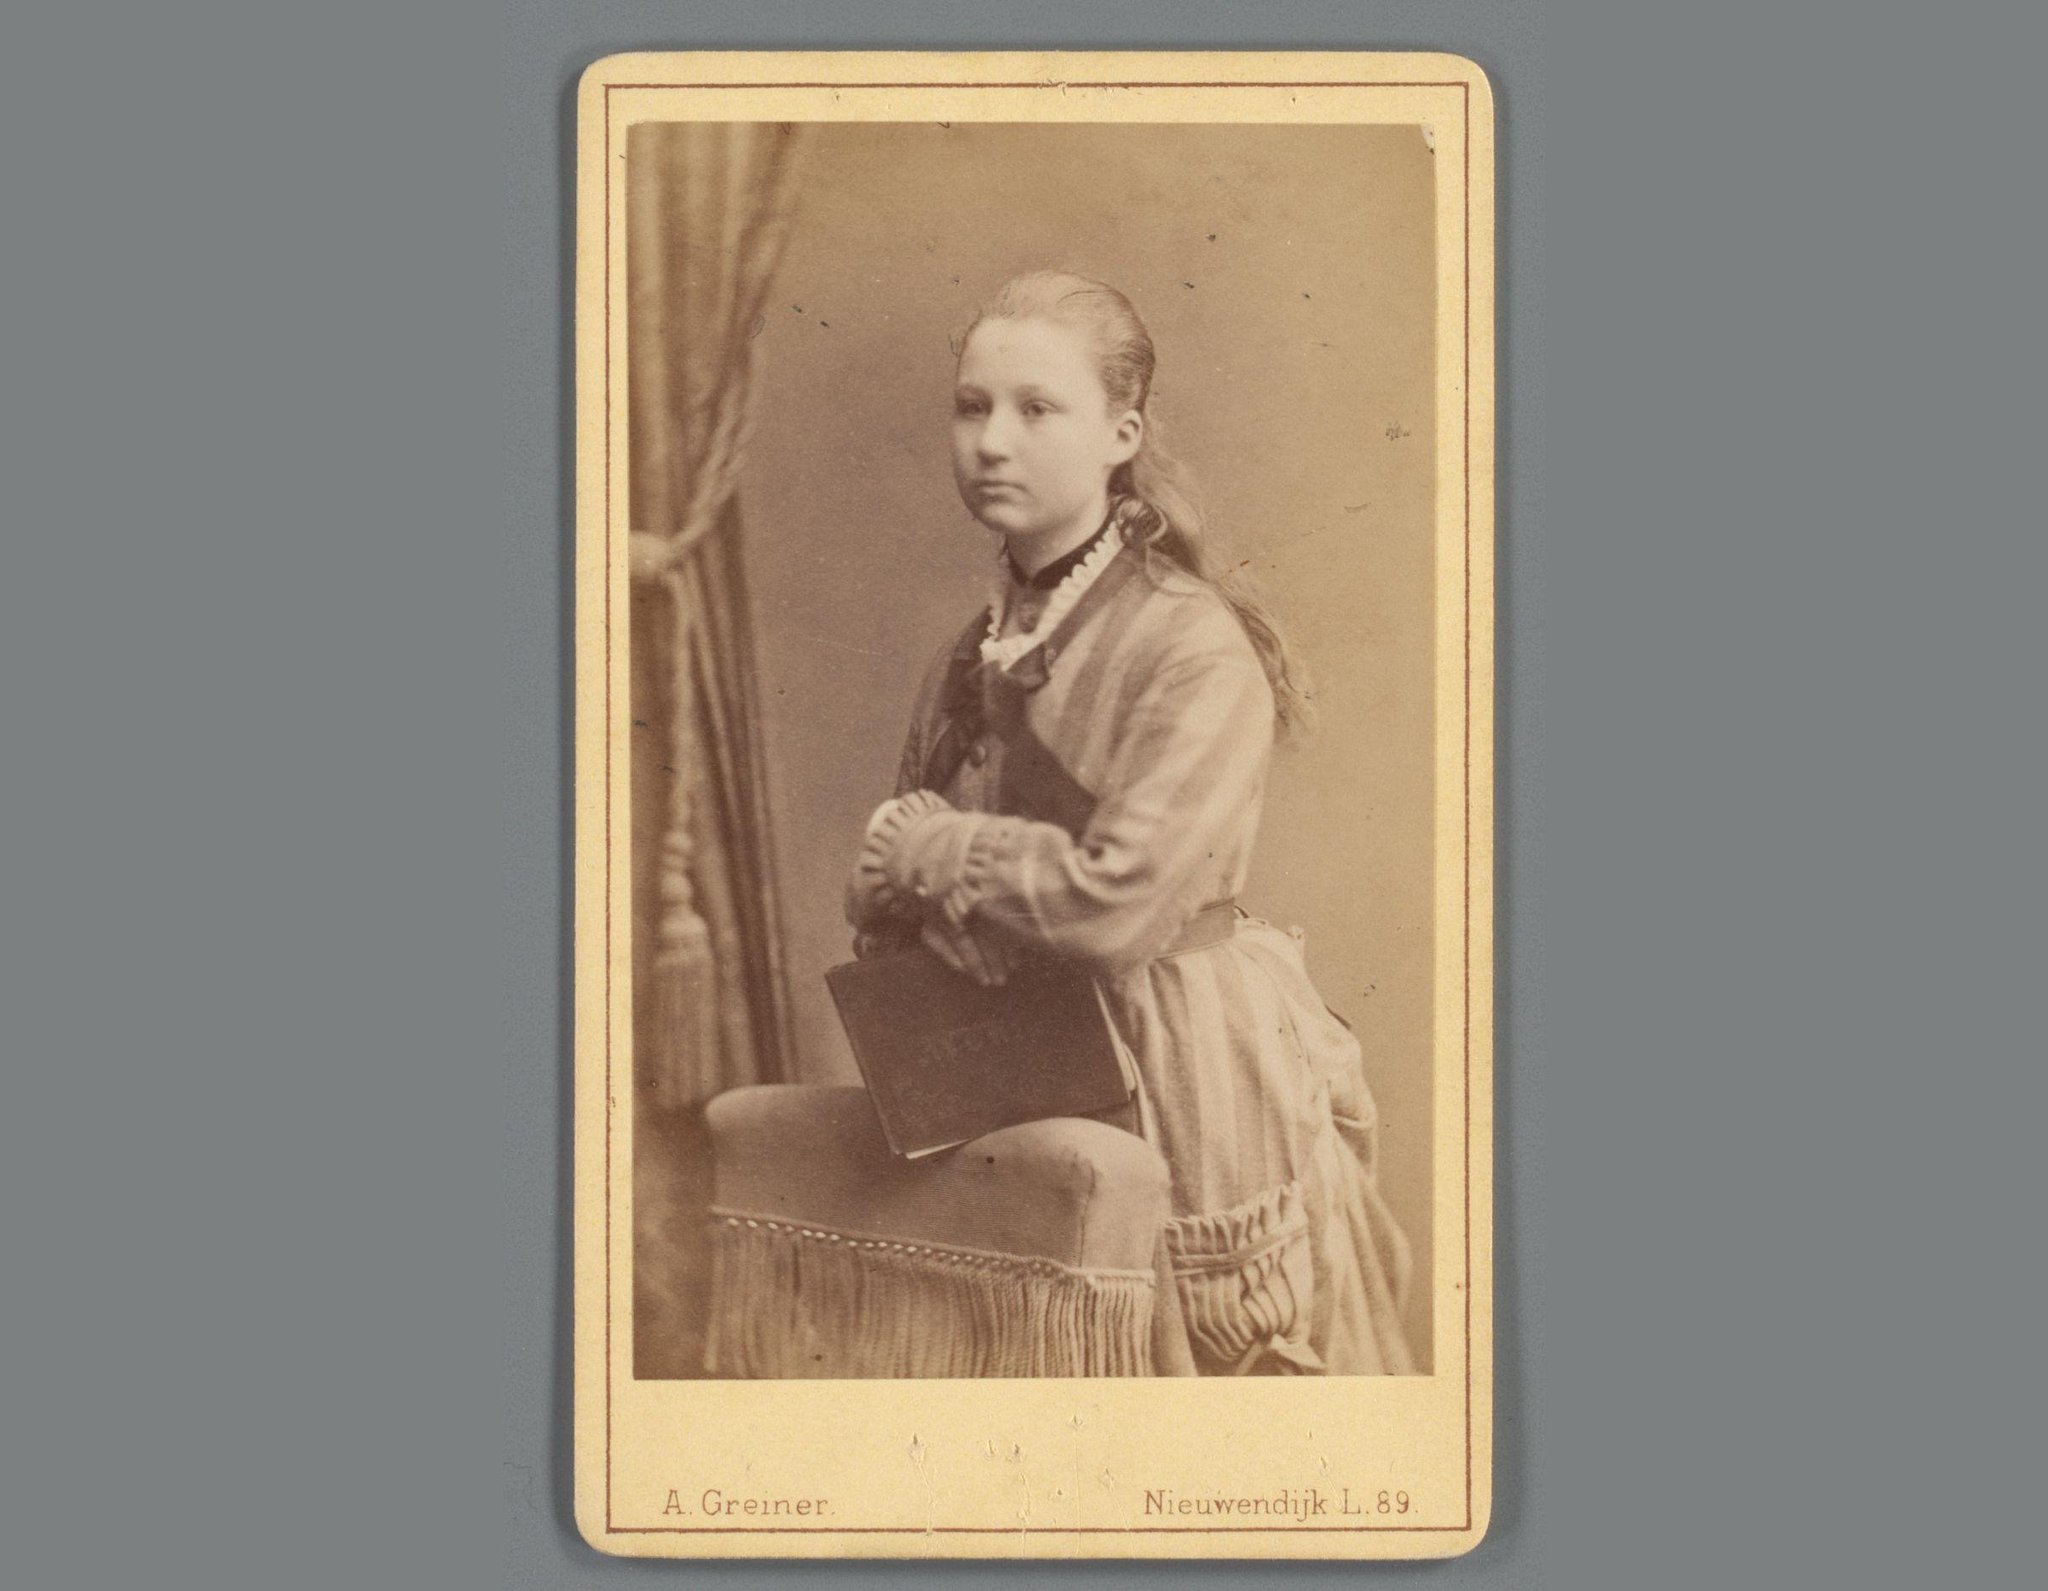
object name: carte de visite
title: Portret van een onbekend meisje uit de familie en de kring van Eugene van Delden en Belle van Delden-Denninghof Stelling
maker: albert greiner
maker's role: fotograaf, fotostudio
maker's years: 1833-1890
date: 1861-1887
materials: cardboard, paper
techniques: albumen print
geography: amsterdam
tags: historical persons not known by name - bb - woman, girl (child between toddler and youth)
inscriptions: inscription: ‘A. GREINER/ Photograf/ AMSTERDAM/ NIEUWENDIJK L. 89.’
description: Portret uit de kring van Eugene van Delden (Hartapoera, 1865 - Den Haag, 1954) en Belle van Delden-Denninghof Stelling (Batavia, 1870 - Den Haag, 1947).